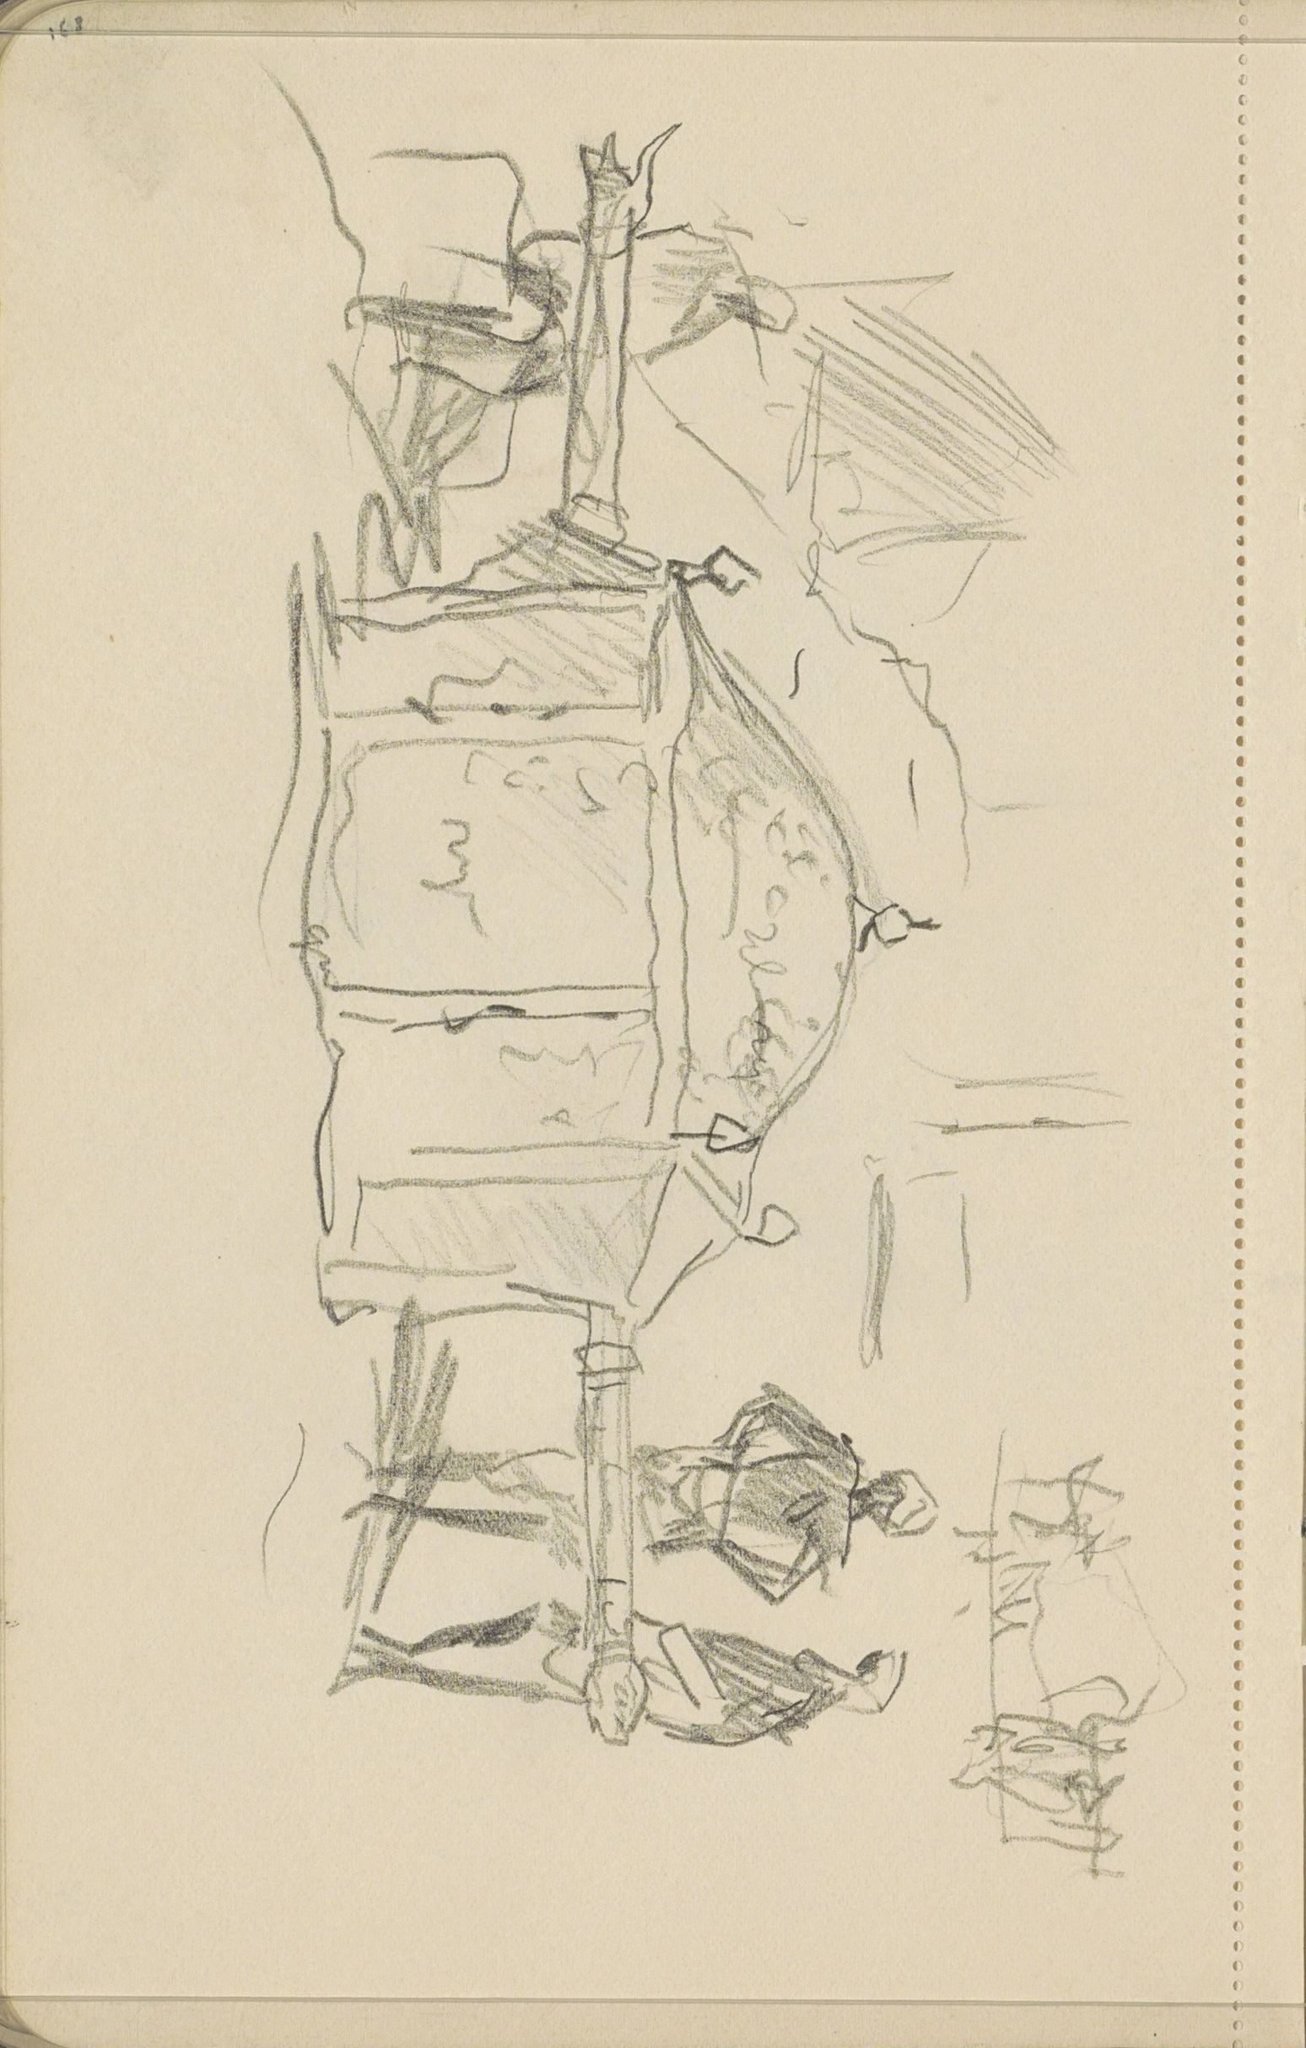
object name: sketchbook leaf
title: Indiërs bij een draagkoets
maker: marius bauer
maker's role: draughtsman, print maker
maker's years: 1867-1932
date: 1924-1925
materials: paper, pencil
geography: india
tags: (carrying a person in a) sedan-chair, asiatic races and peoples: indians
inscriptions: kleurnotitie, handgeschreven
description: Pagina 168 uit een schetsboek met 87 bladen.